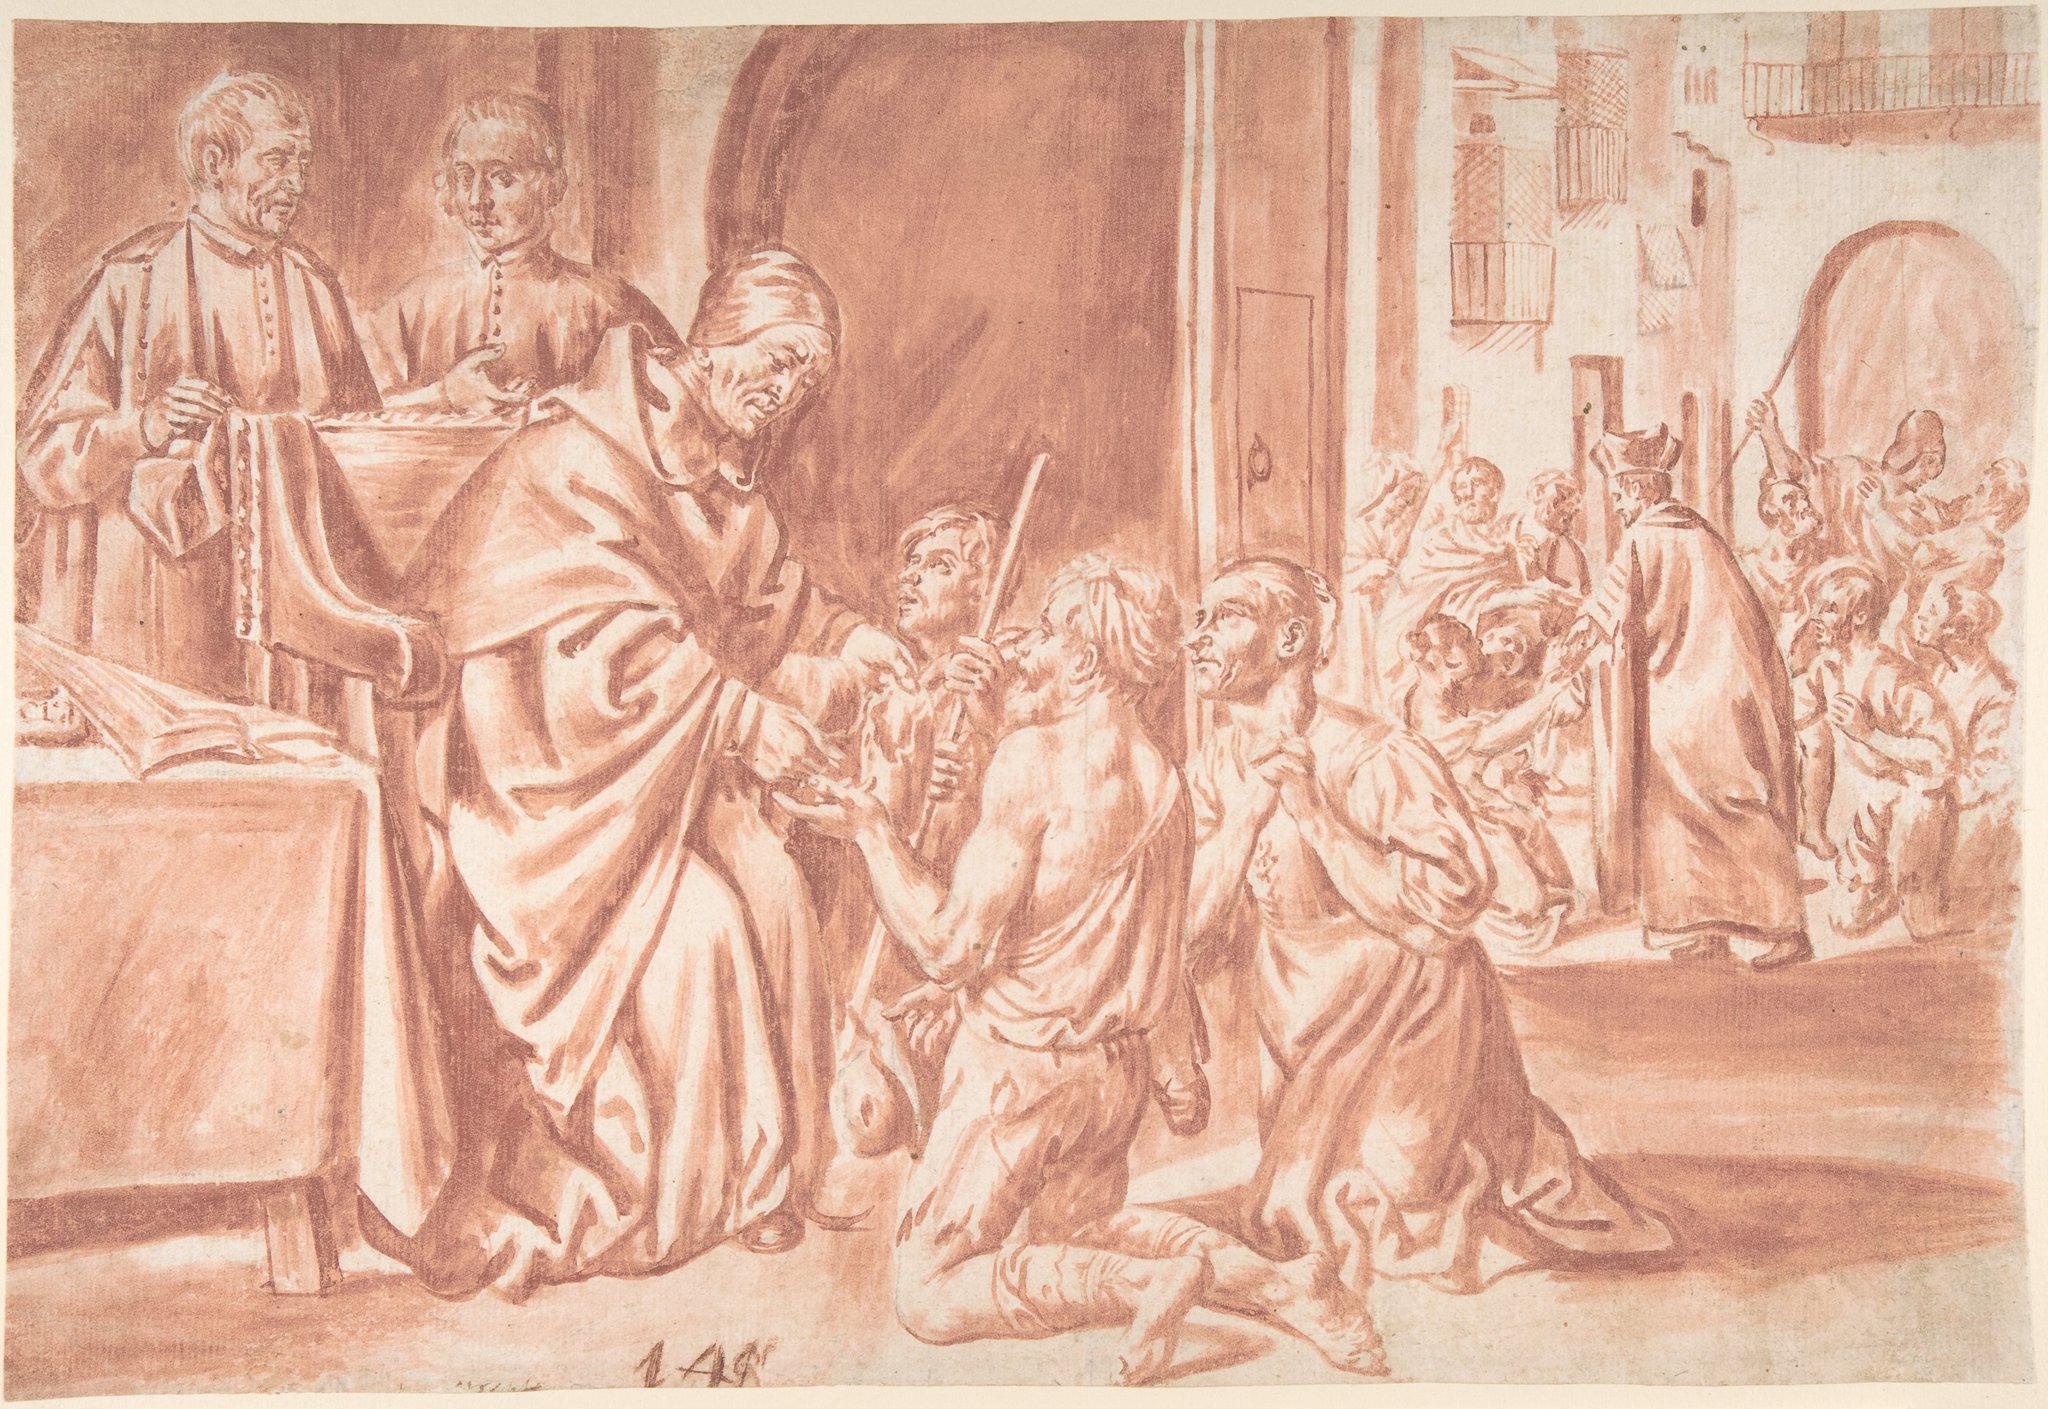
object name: drawing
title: Thomas of Villanova, Archbishop of Valencia Distributing Alms to the Poor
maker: pedro orrente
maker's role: artist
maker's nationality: spanish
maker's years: 1580-1645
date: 1620-1645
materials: chalk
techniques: brush, wash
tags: bishops,crowd